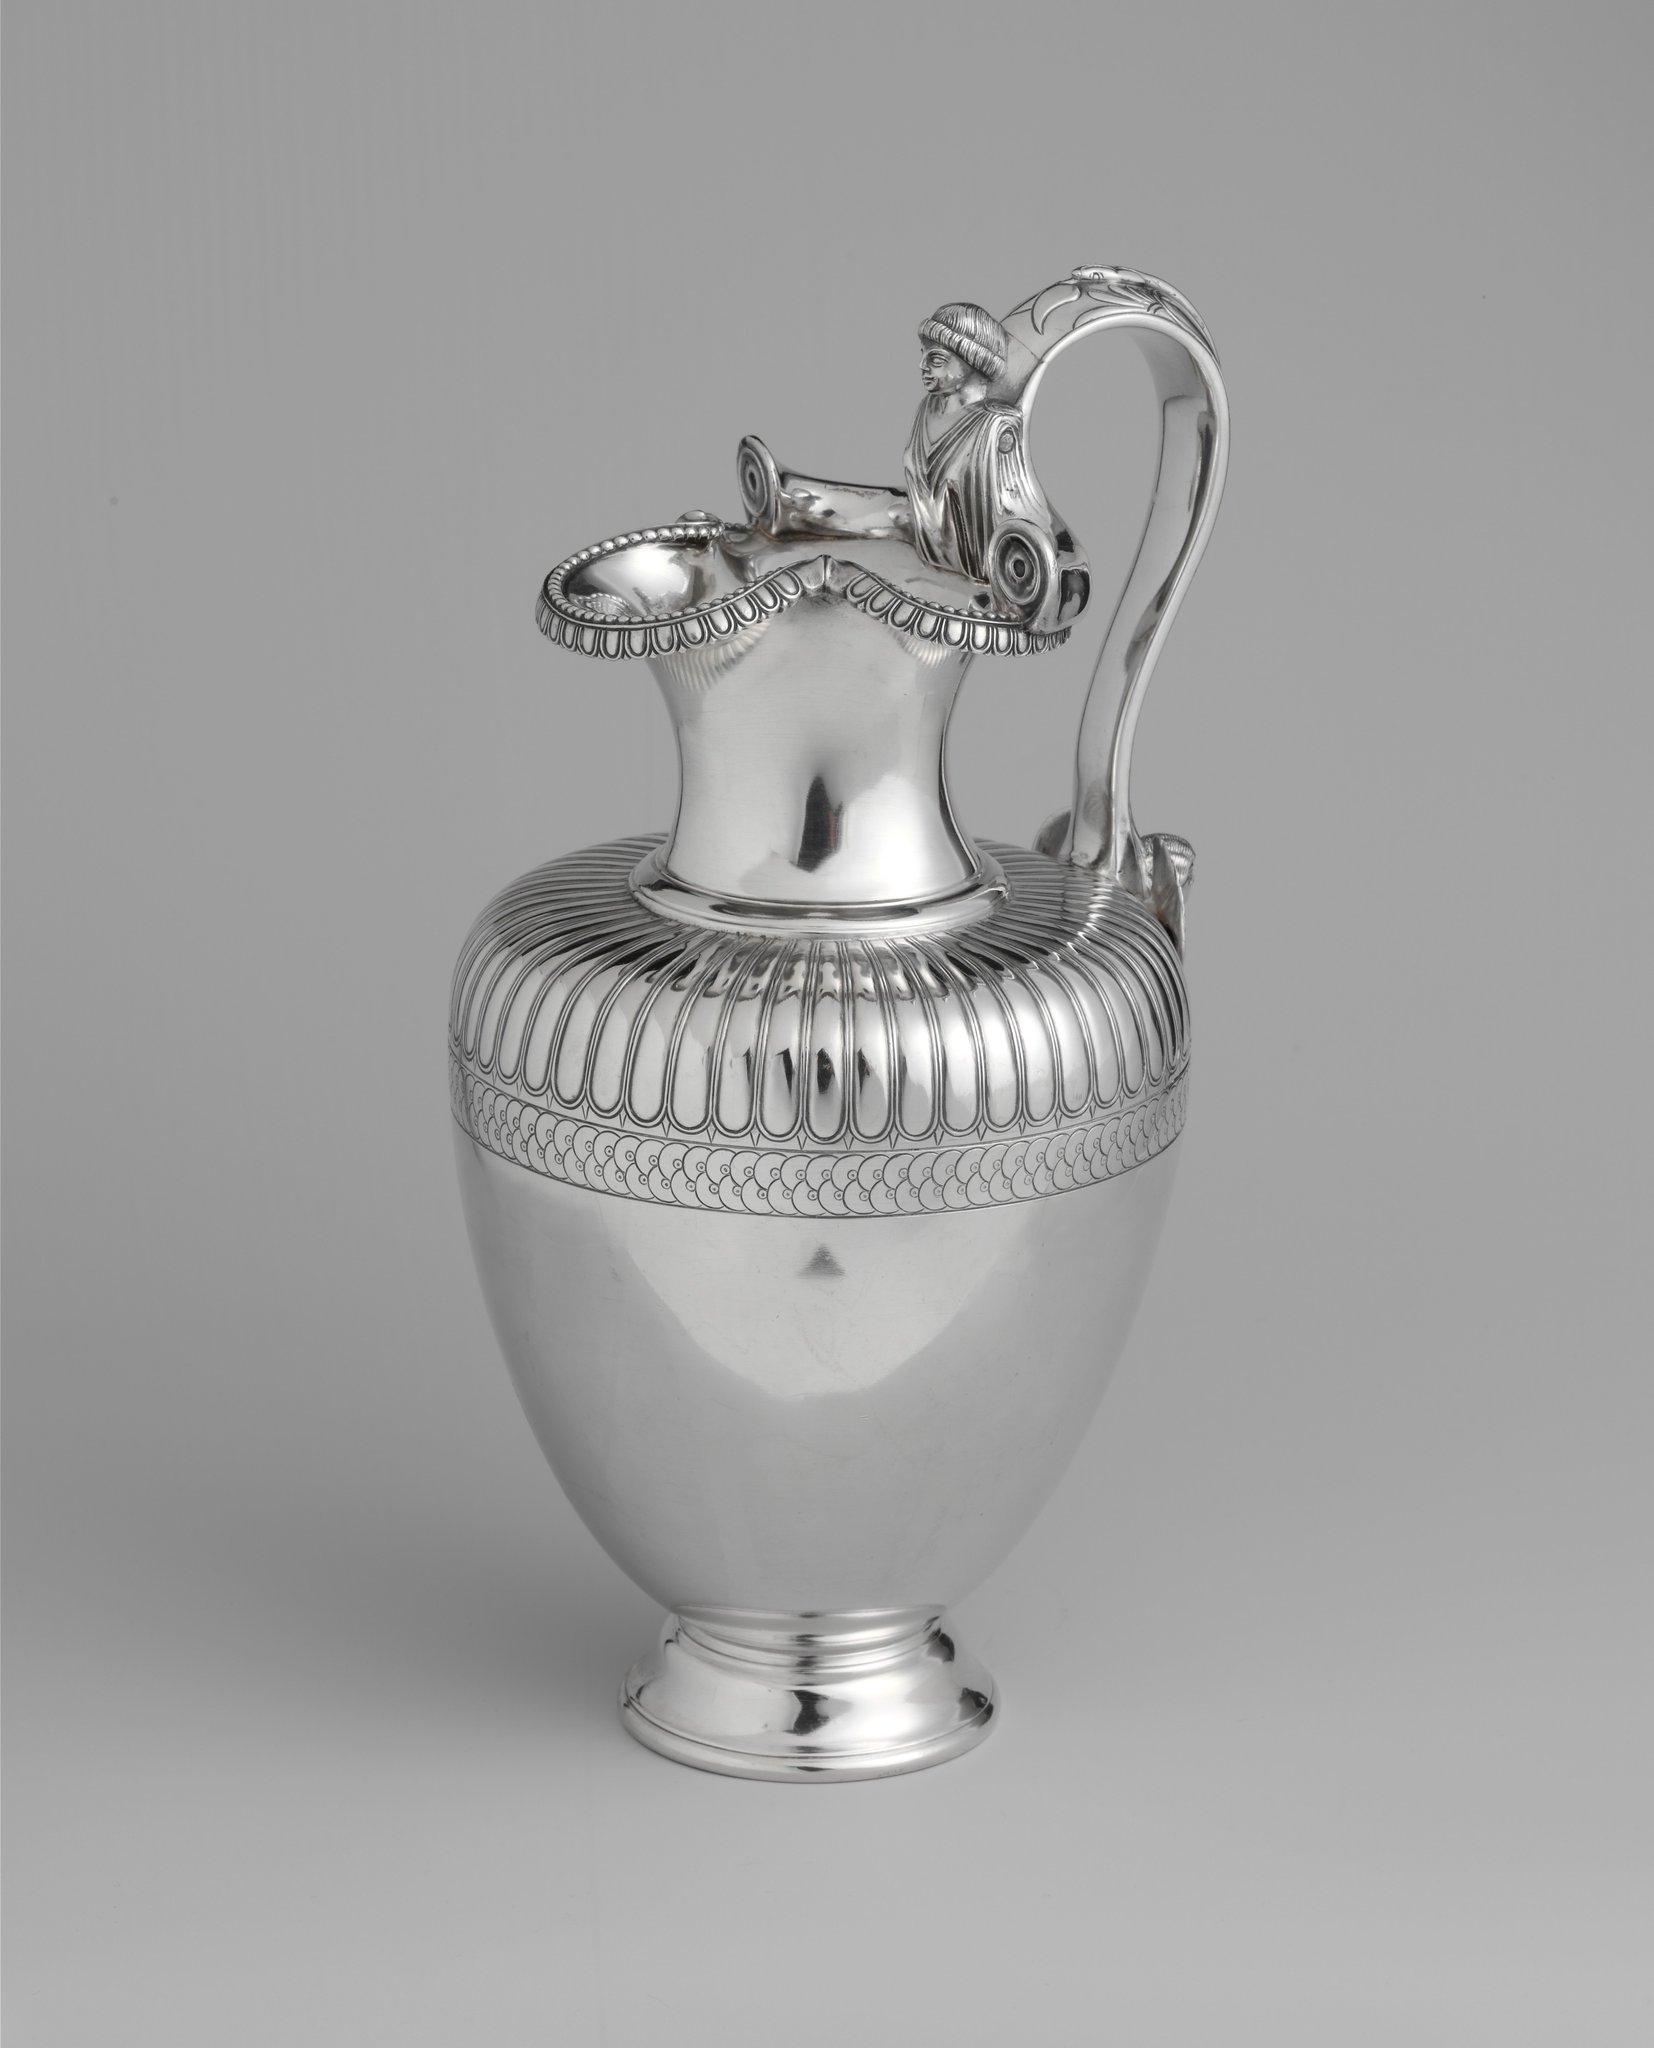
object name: ewer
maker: giacinto melillo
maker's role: maker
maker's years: 1846-1915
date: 1890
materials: silver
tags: men